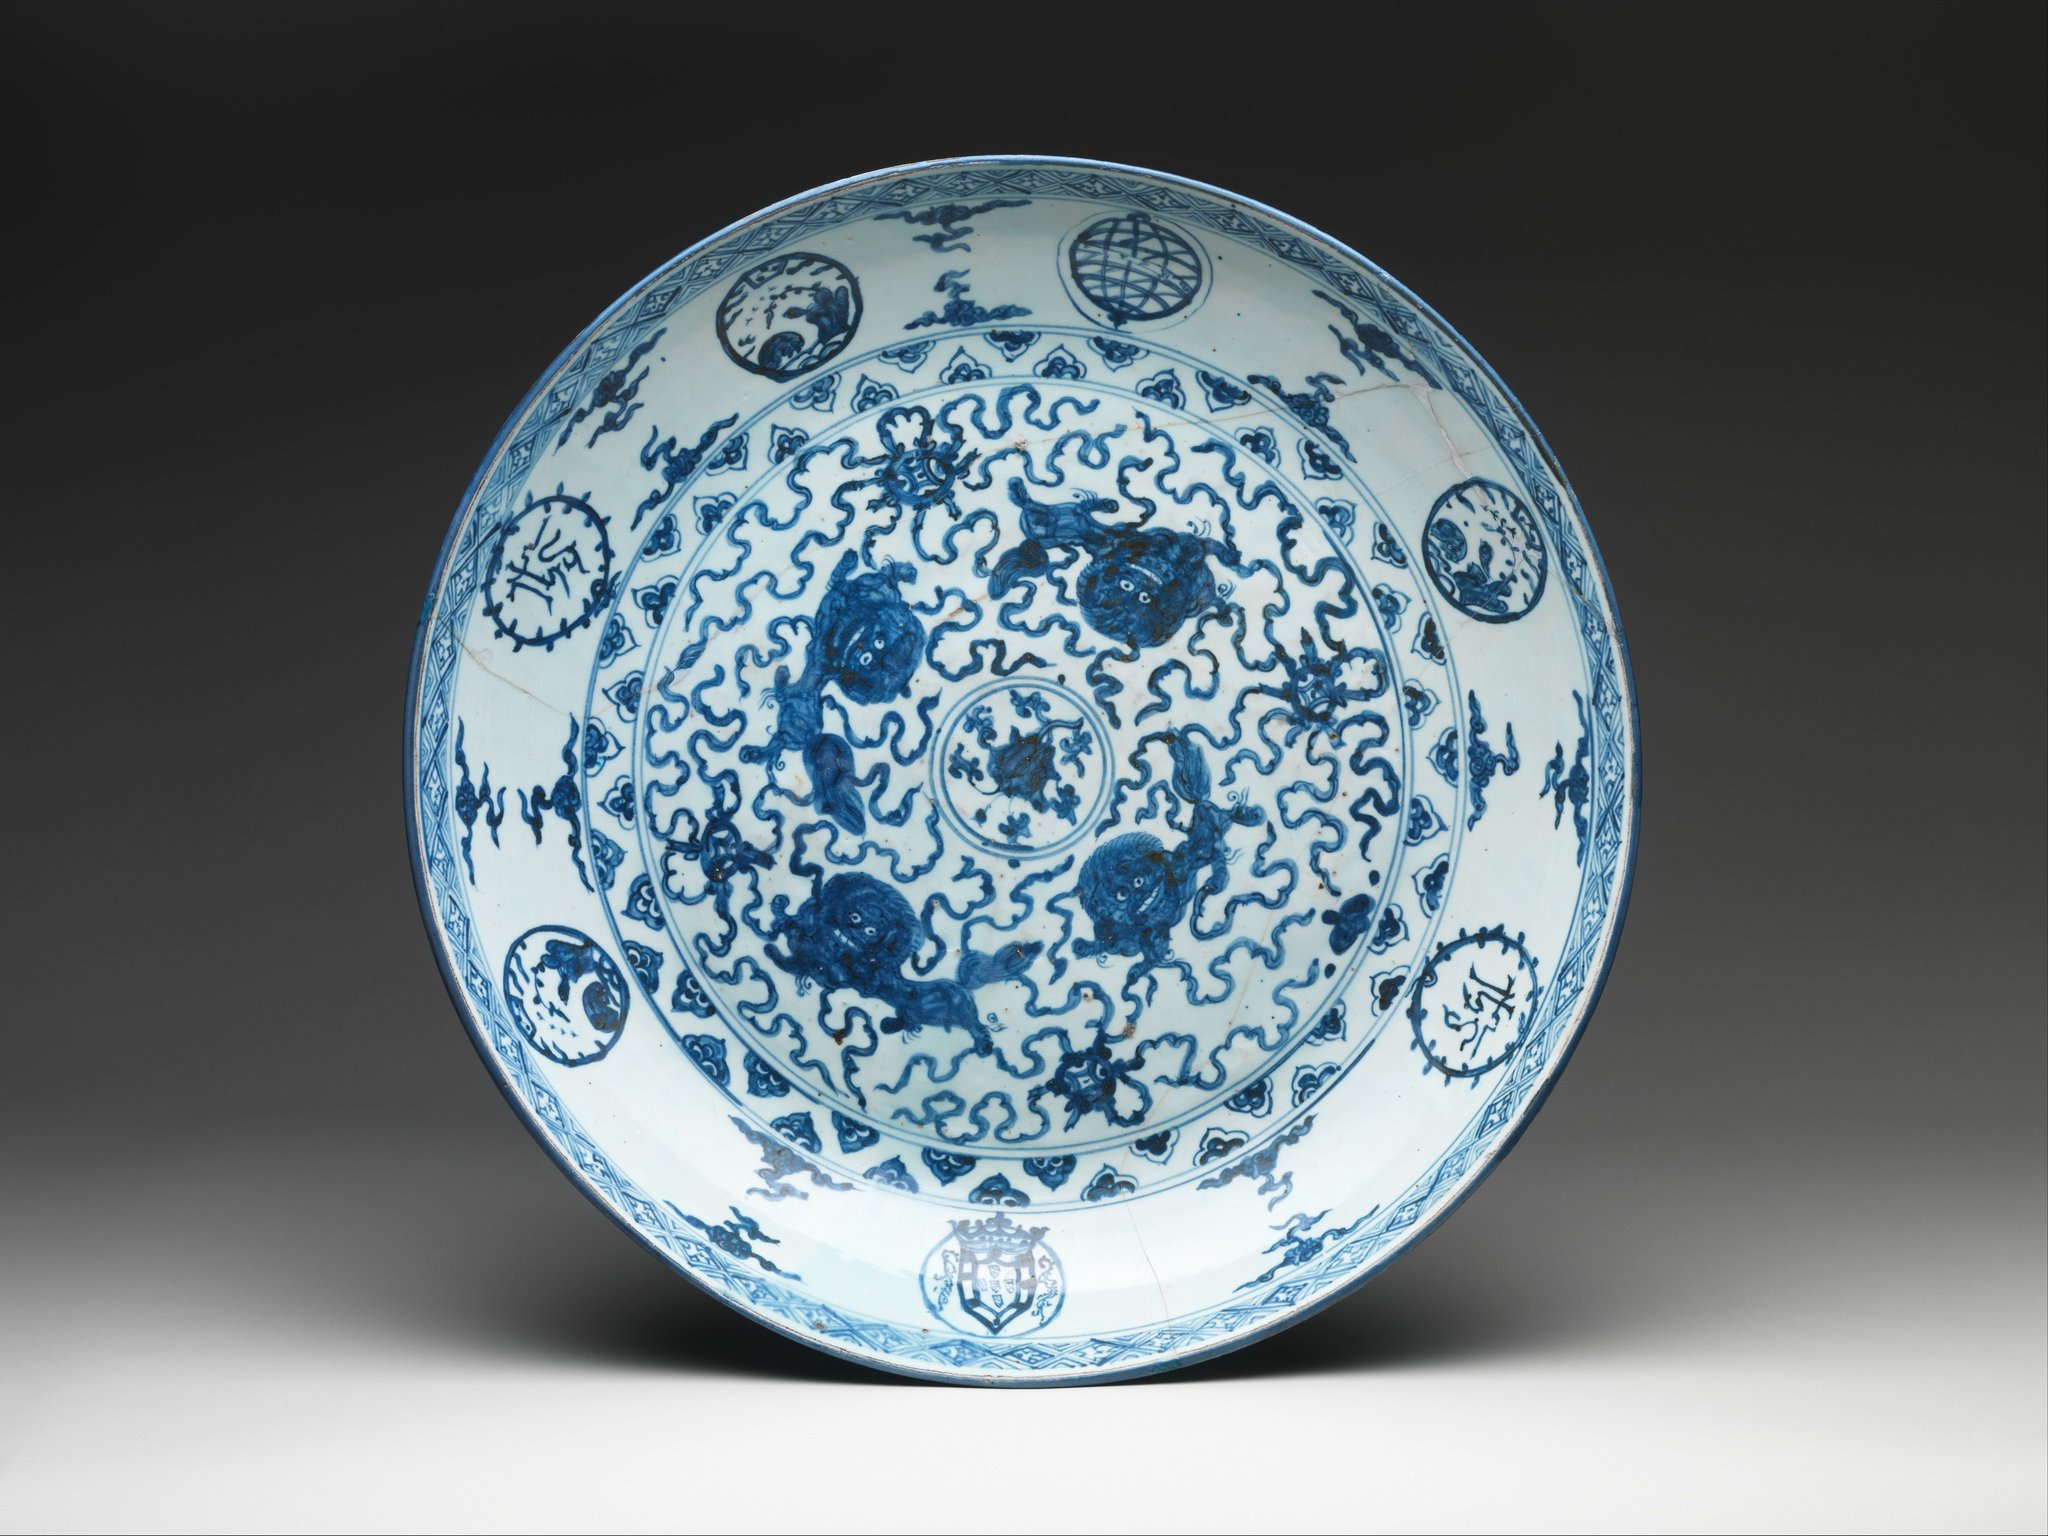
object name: large dish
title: Dish with IHS monogram, armillary sphere, and Portuguese royal arms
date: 1520-1540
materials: cobalt, hard paste porcelain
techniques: underglaze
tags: lions